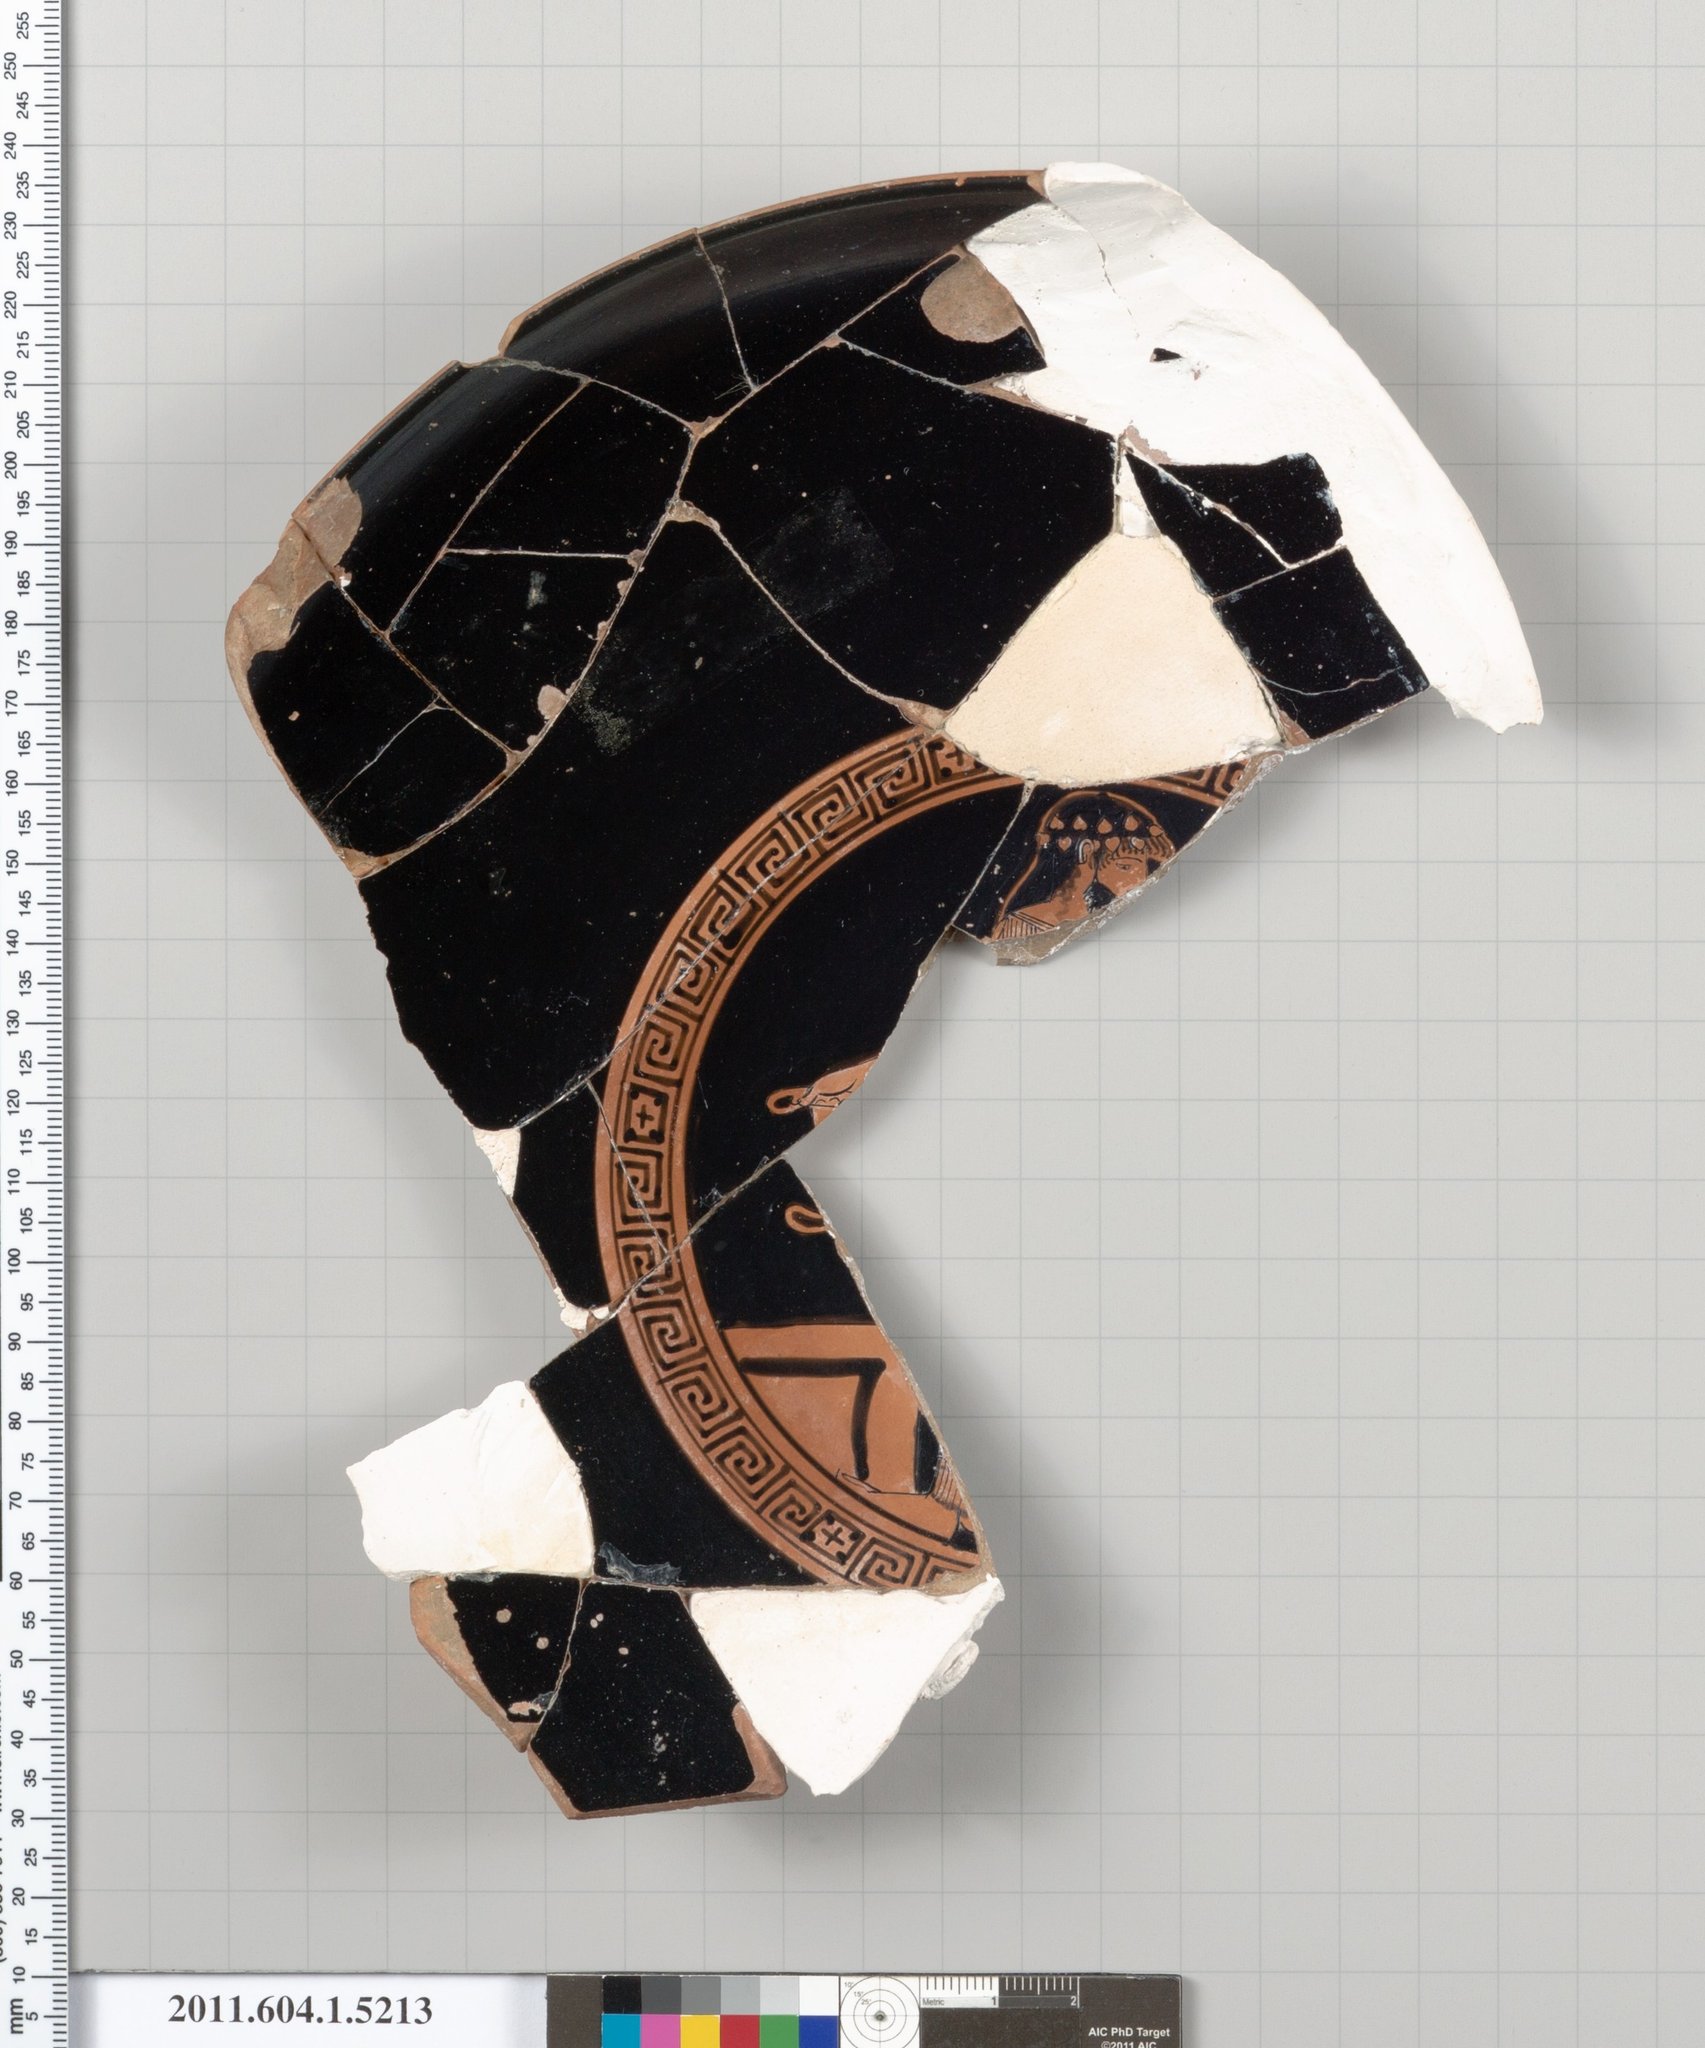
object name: kylix fragment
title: Terracotta fragment of a kylix (drinking cup)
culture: greek, attic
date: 480-470 BCE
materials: terracotta